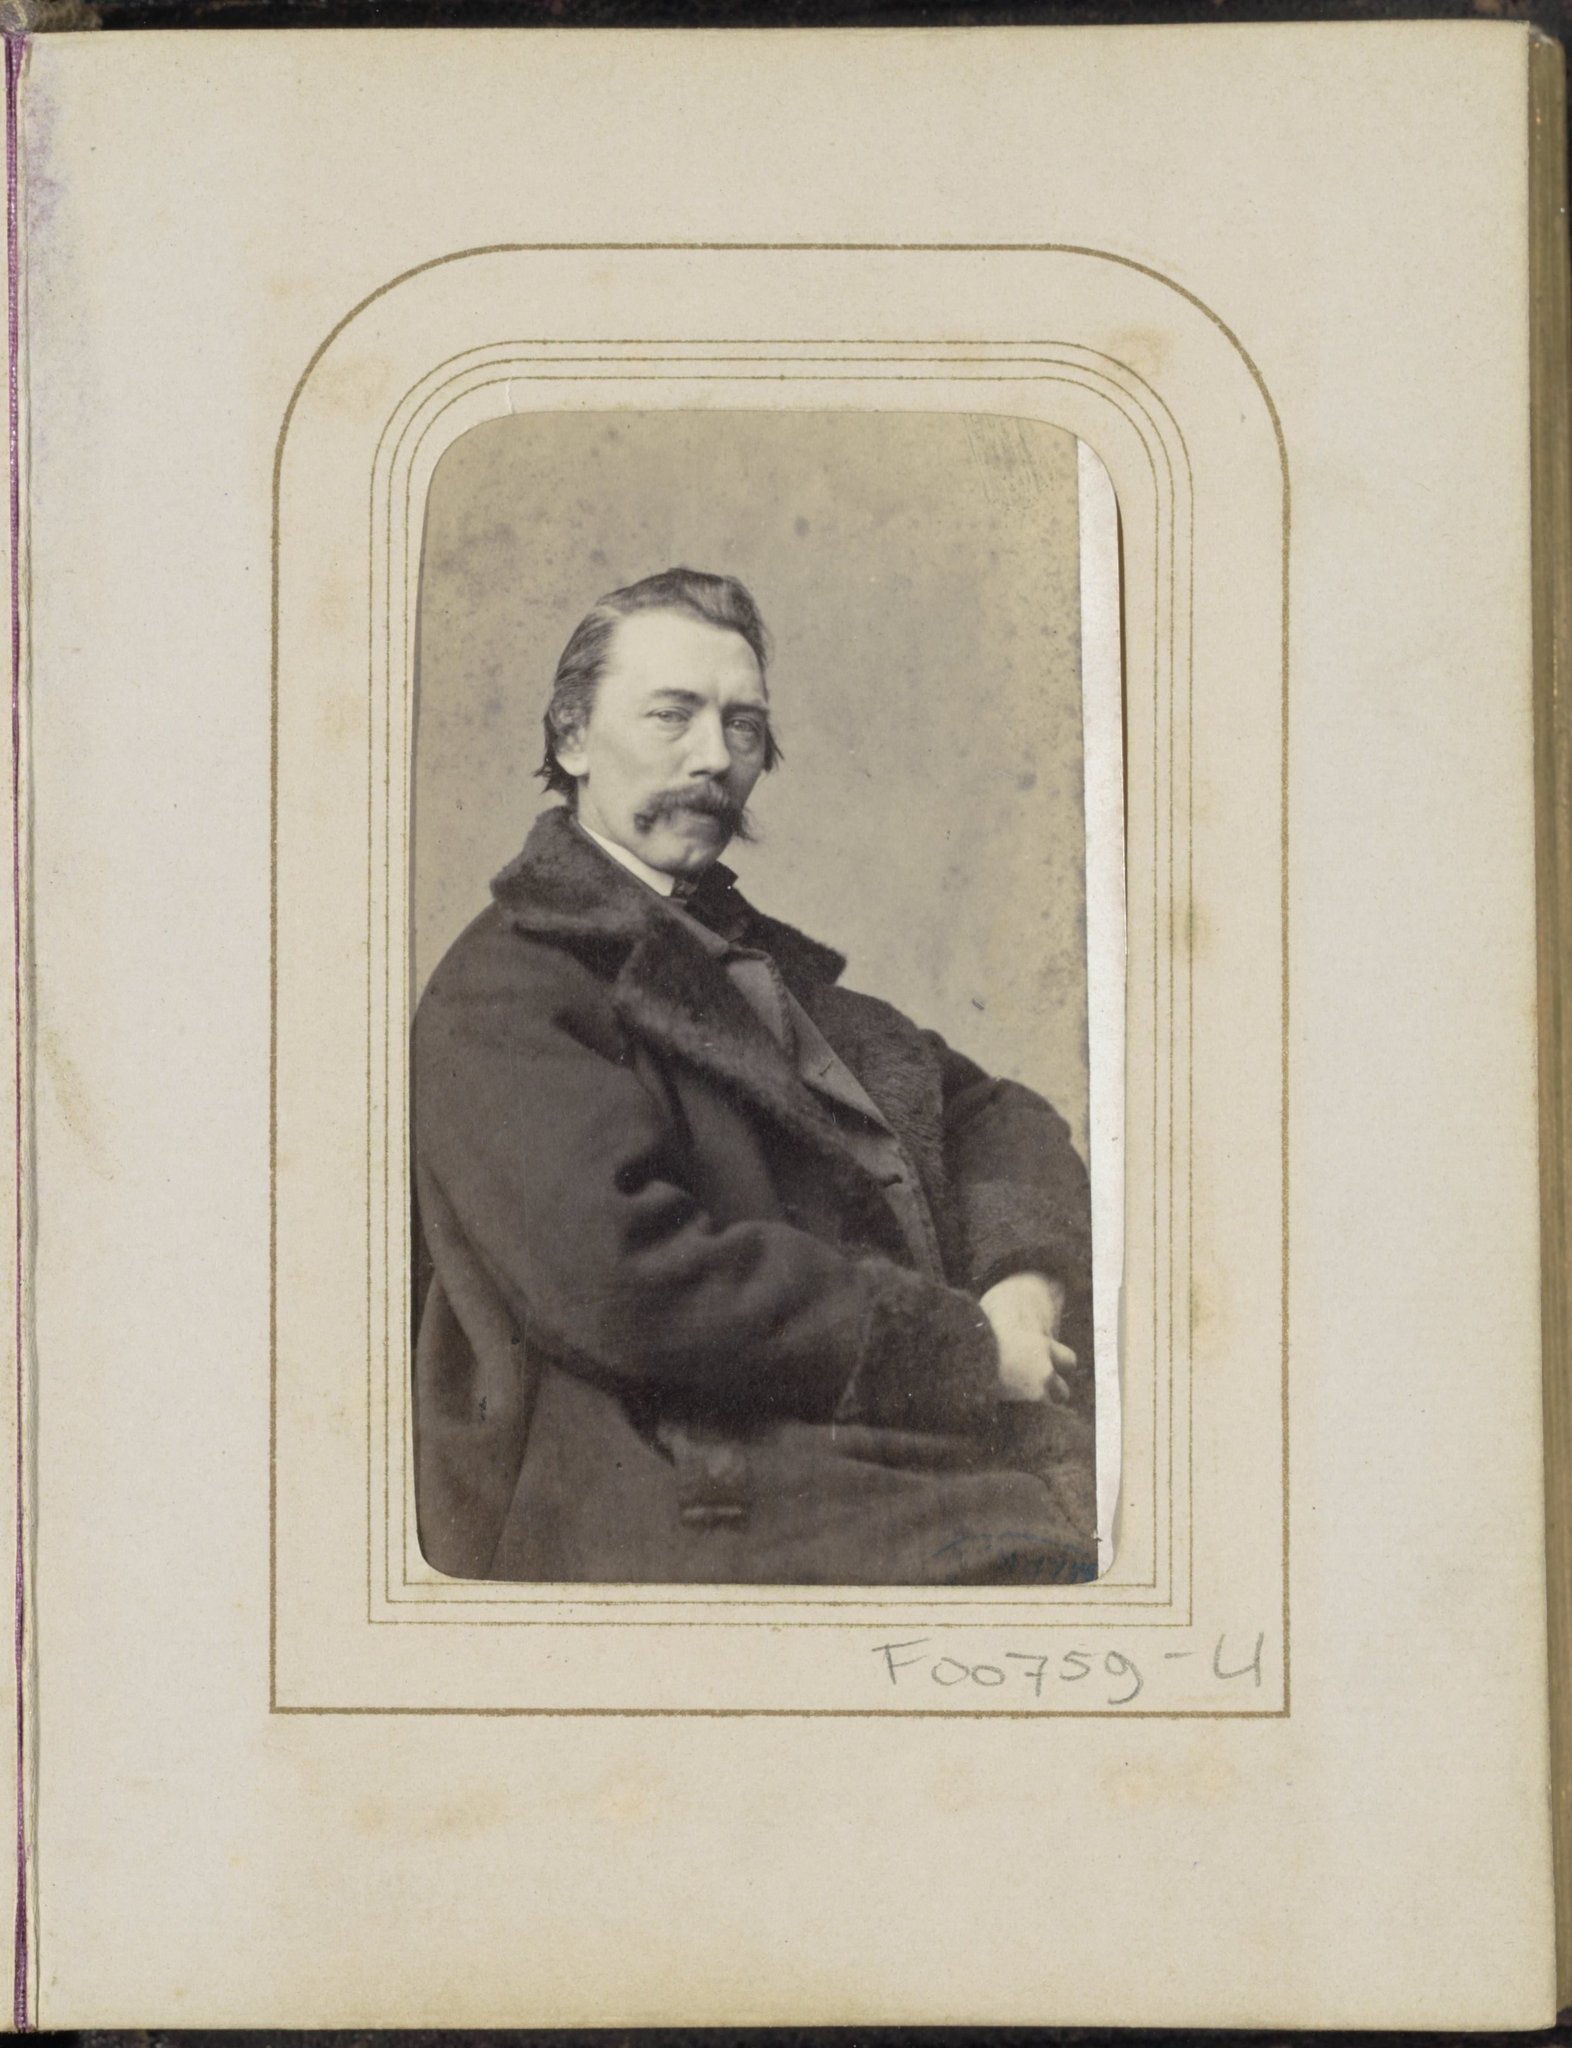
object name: photograph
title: Portret van een man met een snor in een winterjas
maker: theodor brüggemann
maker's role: print maker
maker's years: 1822-1888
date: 1863-1879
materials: cardboard, paper, photographic support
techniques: albumen print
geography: amsterdam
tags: moustache (+ three-quarter view), coat, cape (+ men's clothes), historical persons, clothes covering the entire body, amsterdam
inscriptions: address: ‘Amsterdam, Binnen Amstel bij de Agtergracht Z 198’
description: Onderdeel van Fotoalbum van een Nederlandse familie met 50 cartes-de-visite.